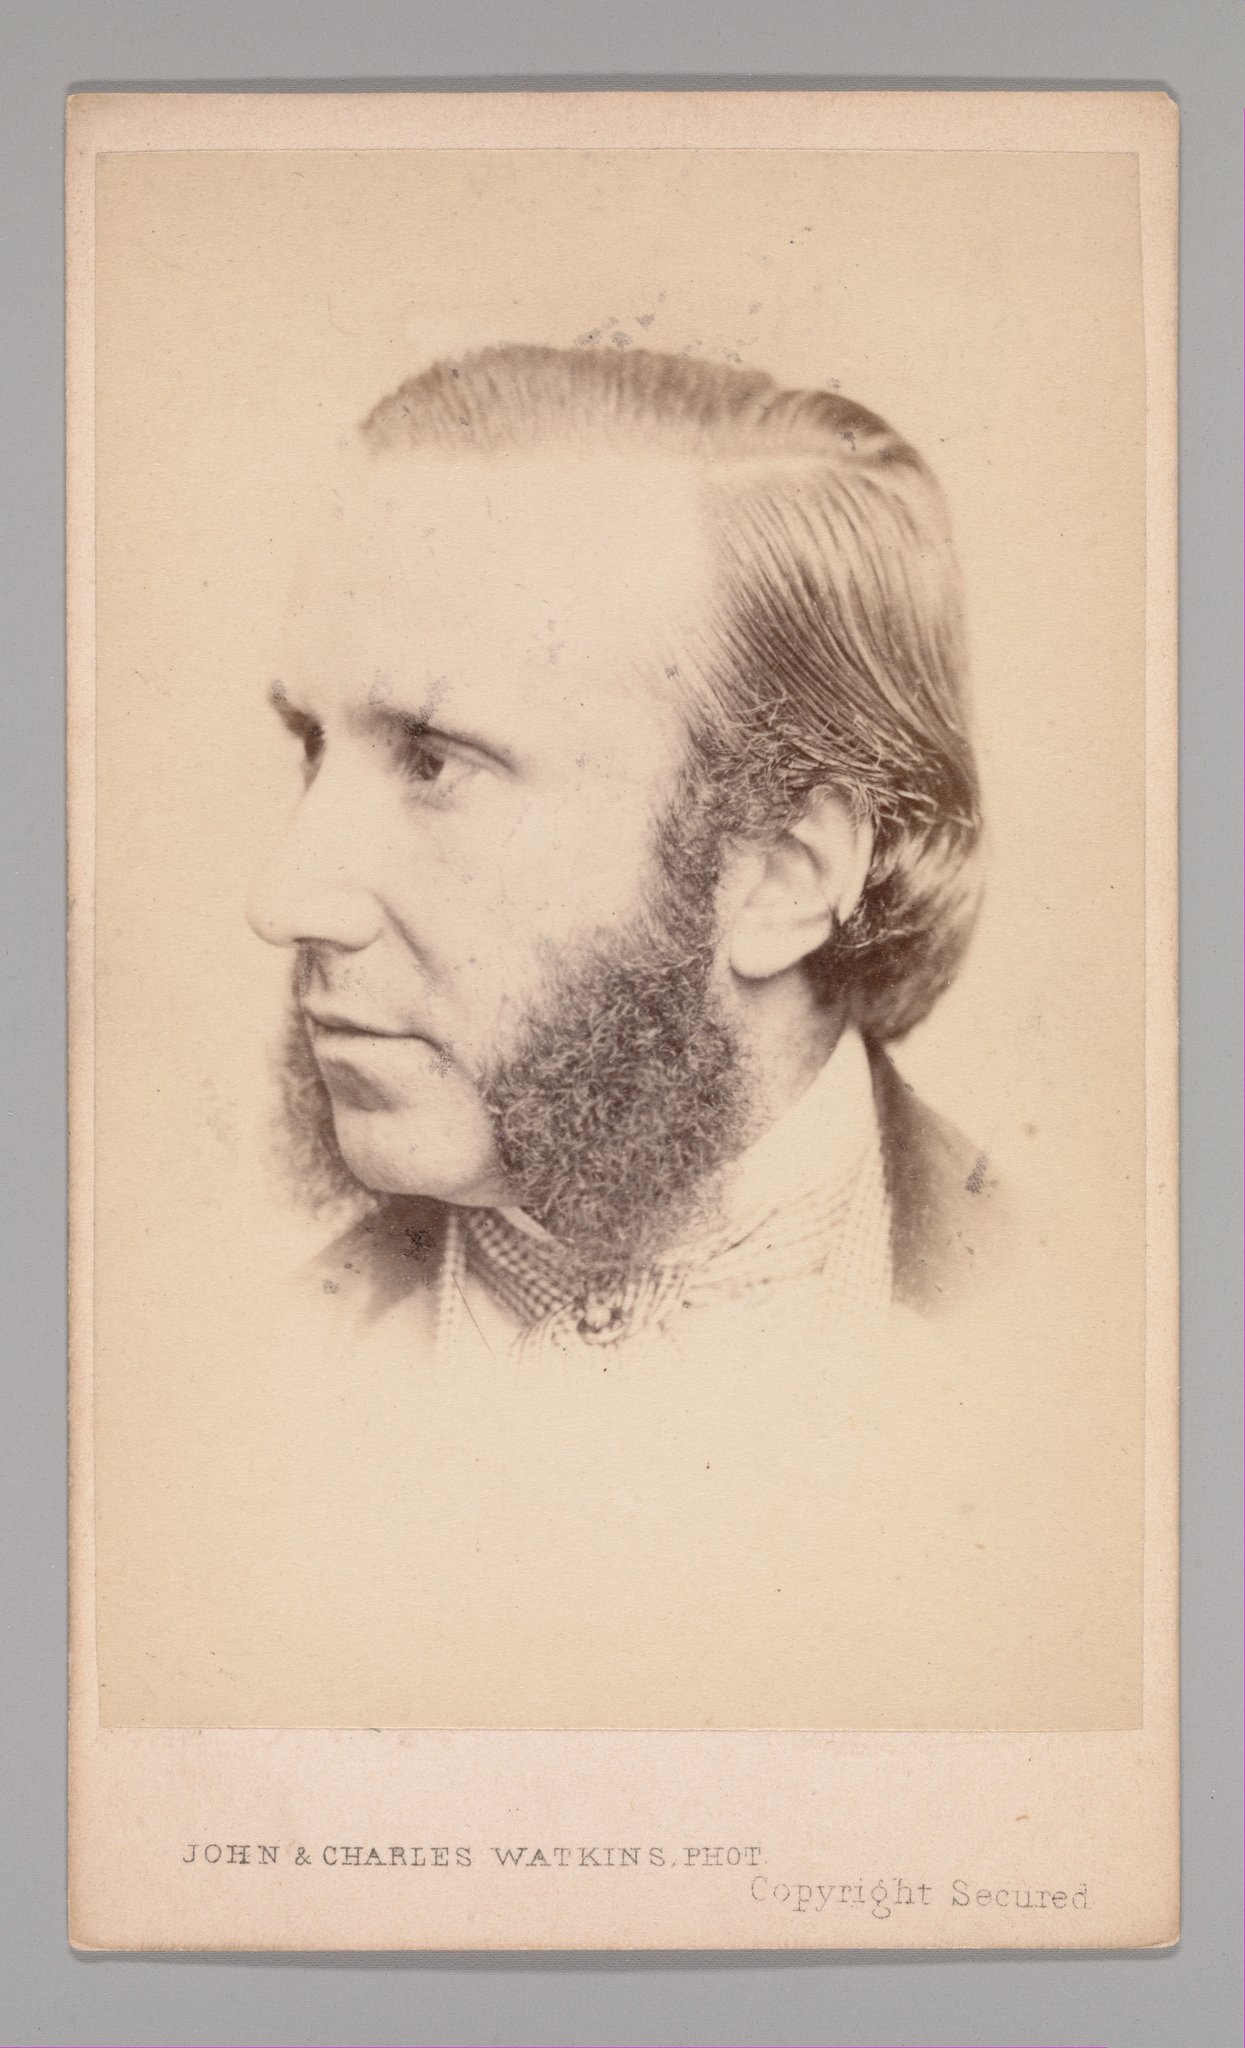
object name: carte de visite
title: [Unknown Subject]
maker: john and charles watkins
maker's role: photography studio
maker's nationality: british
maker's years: 1840-1875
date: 1860-1869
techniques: albumen silver print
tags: men,portraits